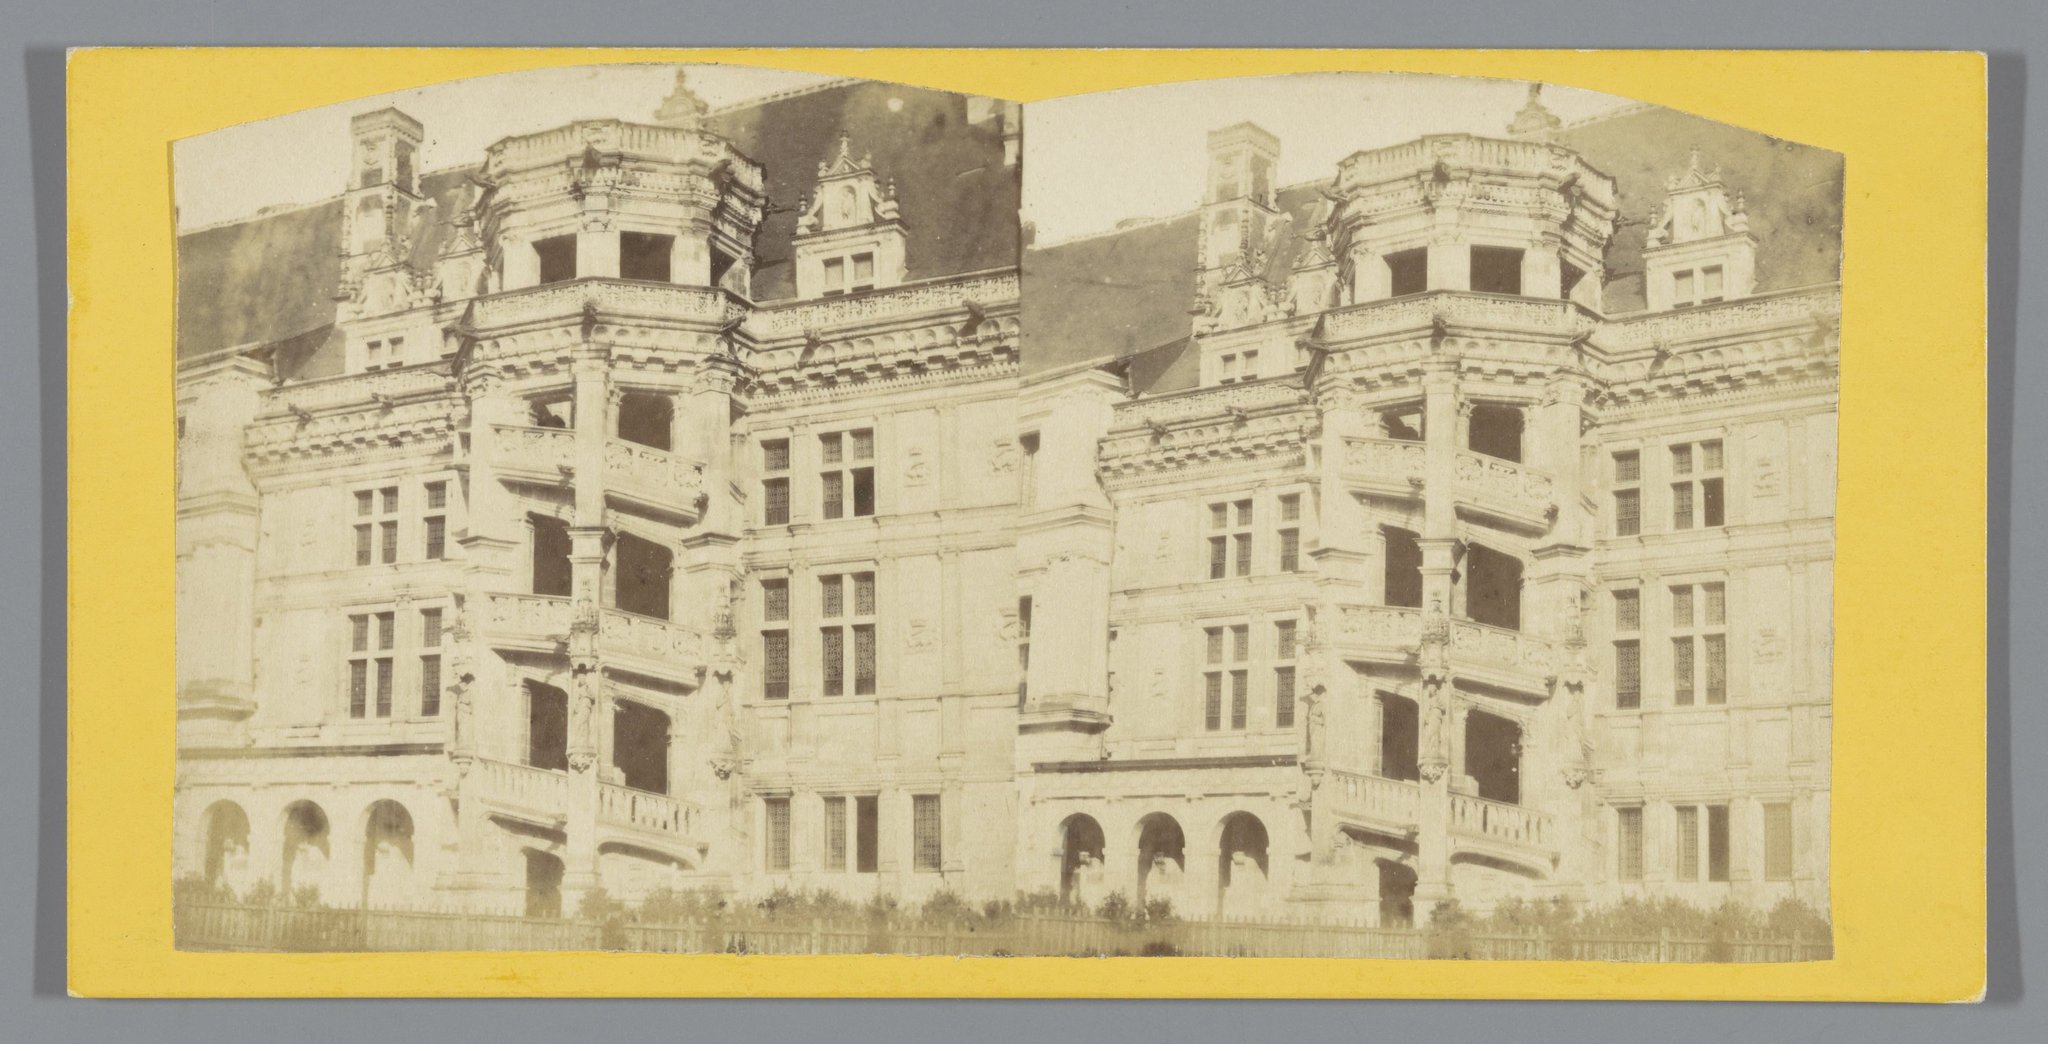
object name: stereograph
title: Exterieur van het trappenhuis van het Kasteel van Blois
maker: Anonymous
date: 1860-1880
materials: cardboard, photographic support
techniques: albumen print, photography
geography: blois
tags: castle, façade (of house or building)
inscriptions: inscription: ‘Blois, escalier francois’